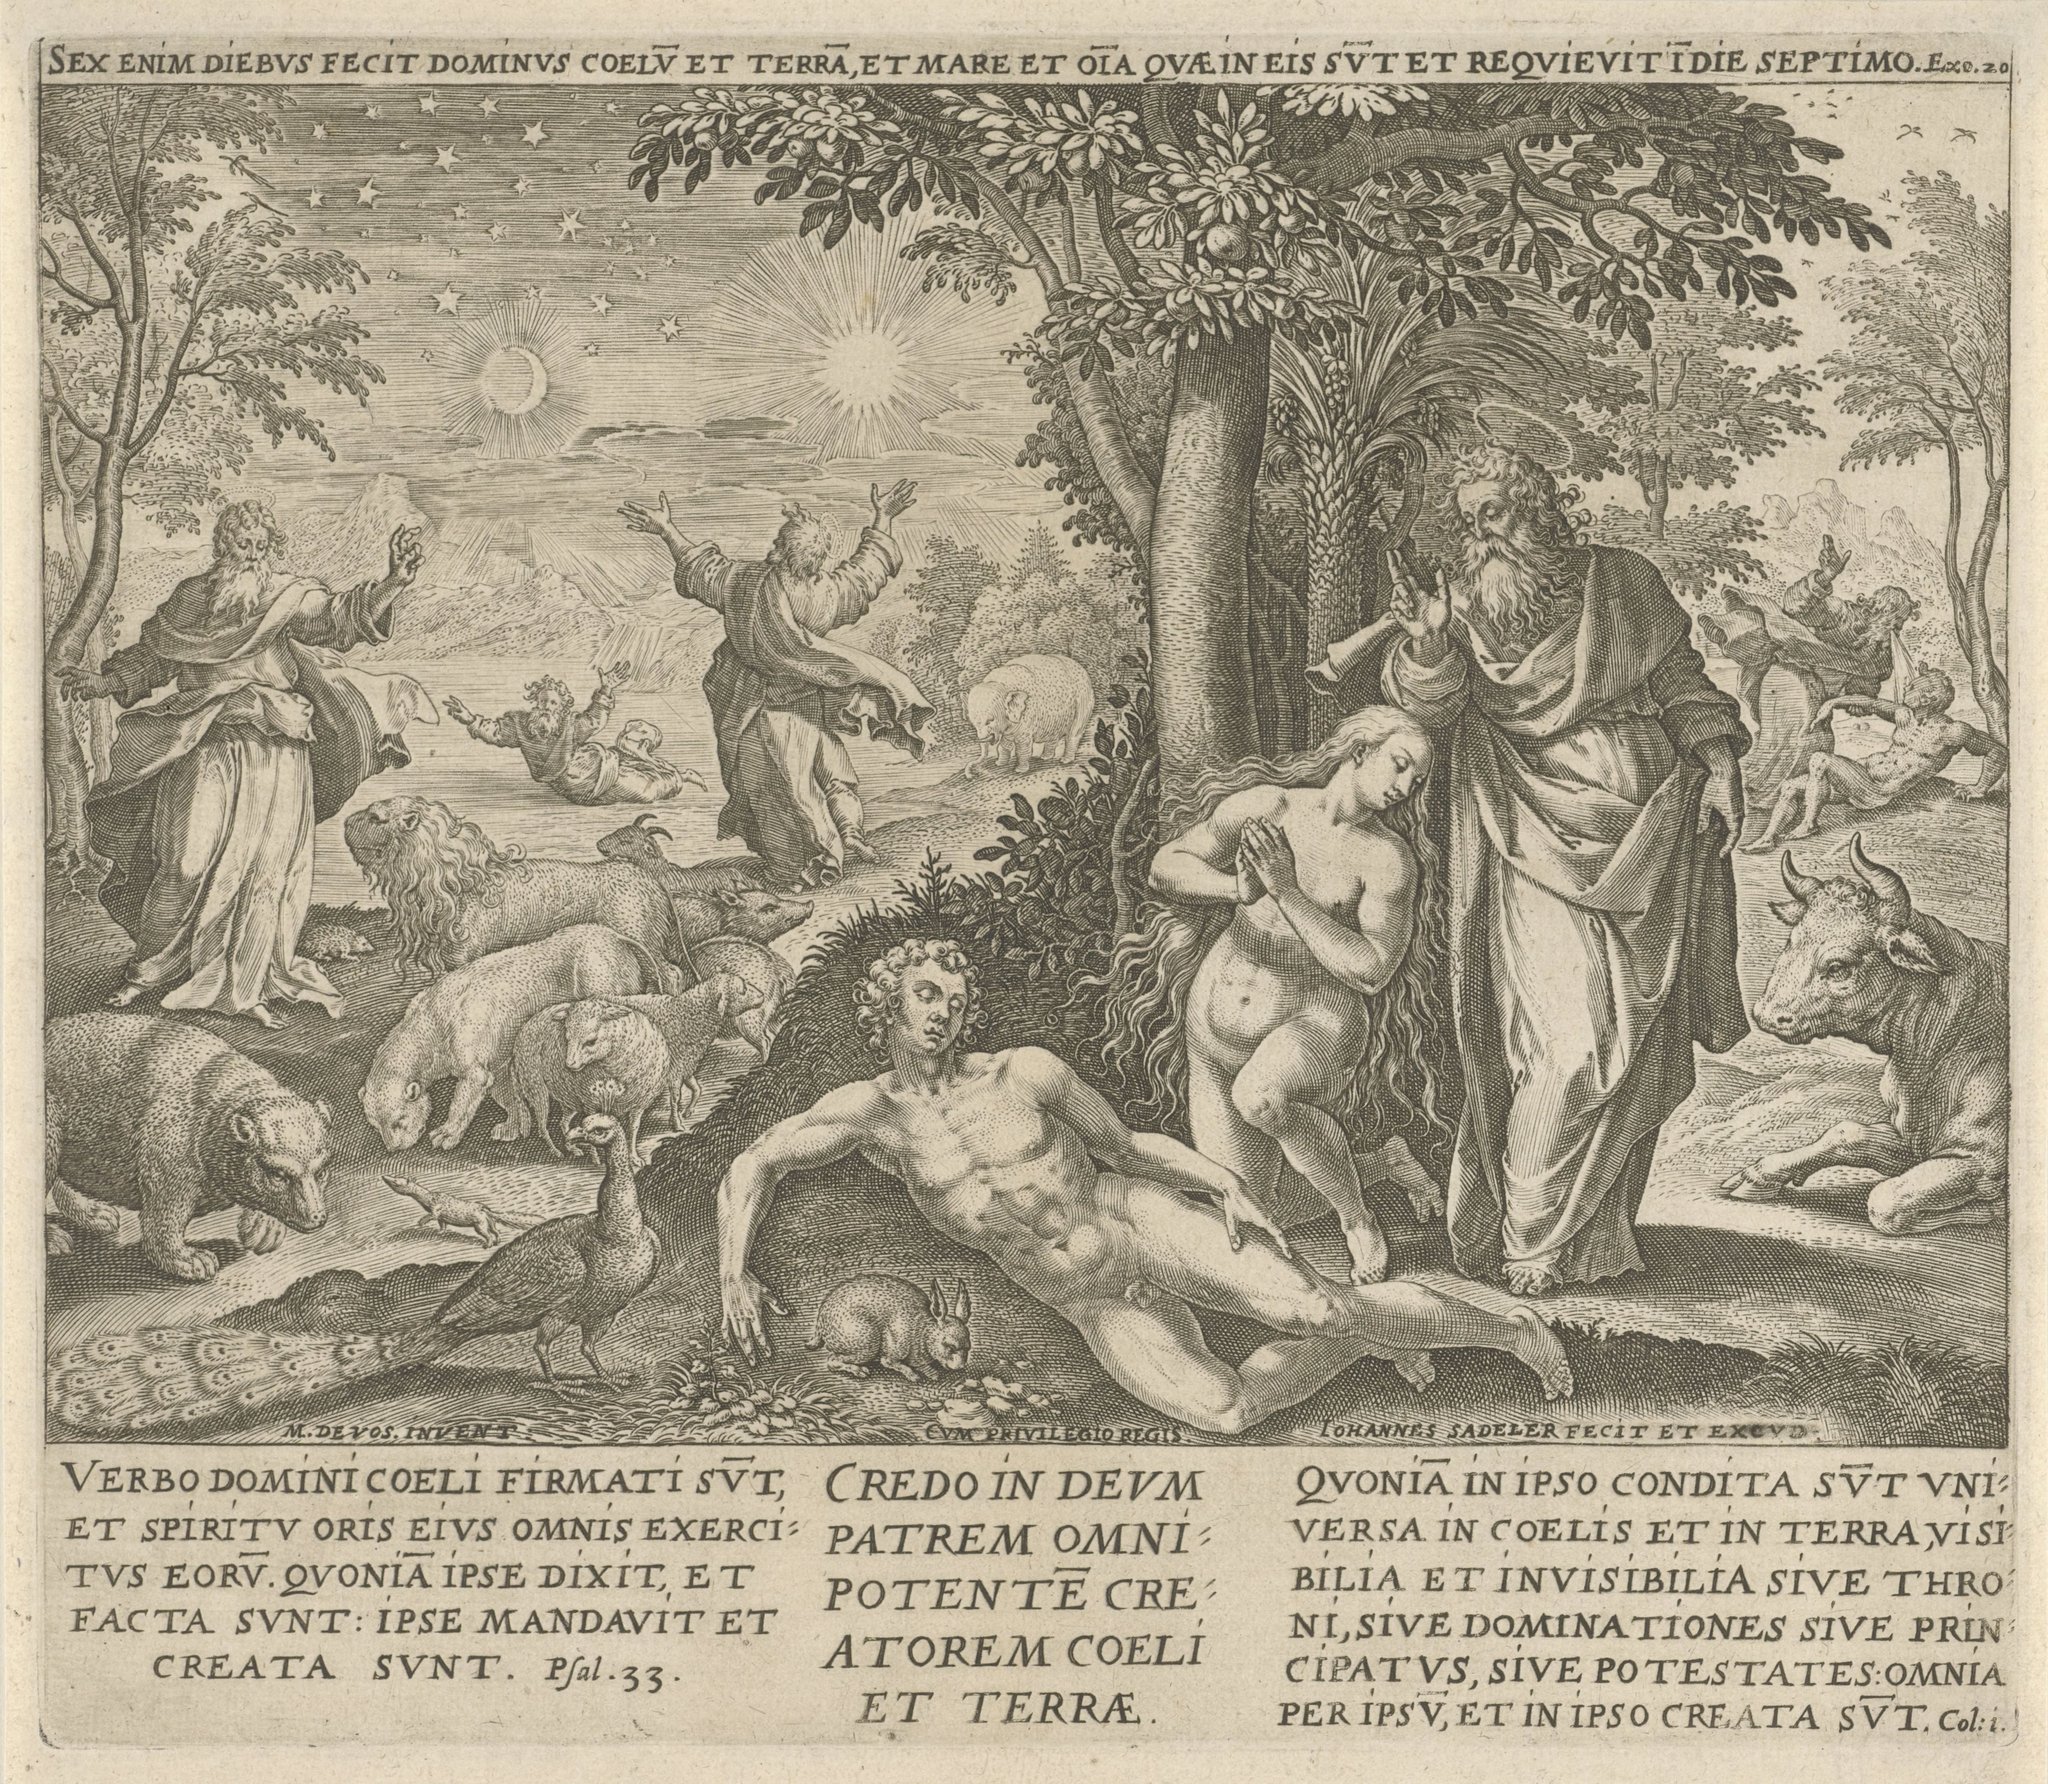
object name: print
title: Schepping van Eva: 'ik geloof in God, de almachtige Vader, Schepper van hemel en aarde'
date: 1579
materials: paper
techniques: engraving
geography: cologne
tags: genesis from the creation to the expulsion from paradise, and later years of adam and eve, 'credo in deum patrem omnipotentem, creatorem coeli et terrae' ~ articles of faith, creation of eve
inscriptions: collector's mark: Lugt 240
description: Het eerste geloofsartikel: het geloof in één God, Schepper van hemel en aarde. God de Vader schept Eva uit Adams rib. Rechts op de achtergrond buigt God de Vader zich over Adam en blaast hem leven in. Links de schepping van de wereld en van de dieren. De prent heeft een Latijns opschrift met een Bijbelcitaat dat refereert naar het afgebeelde Bijbelverhaal en een Latijns onderschrift over de apostolische geloofsbelijdenis. De eerste prent in een twaalfdelige serie over het credo.